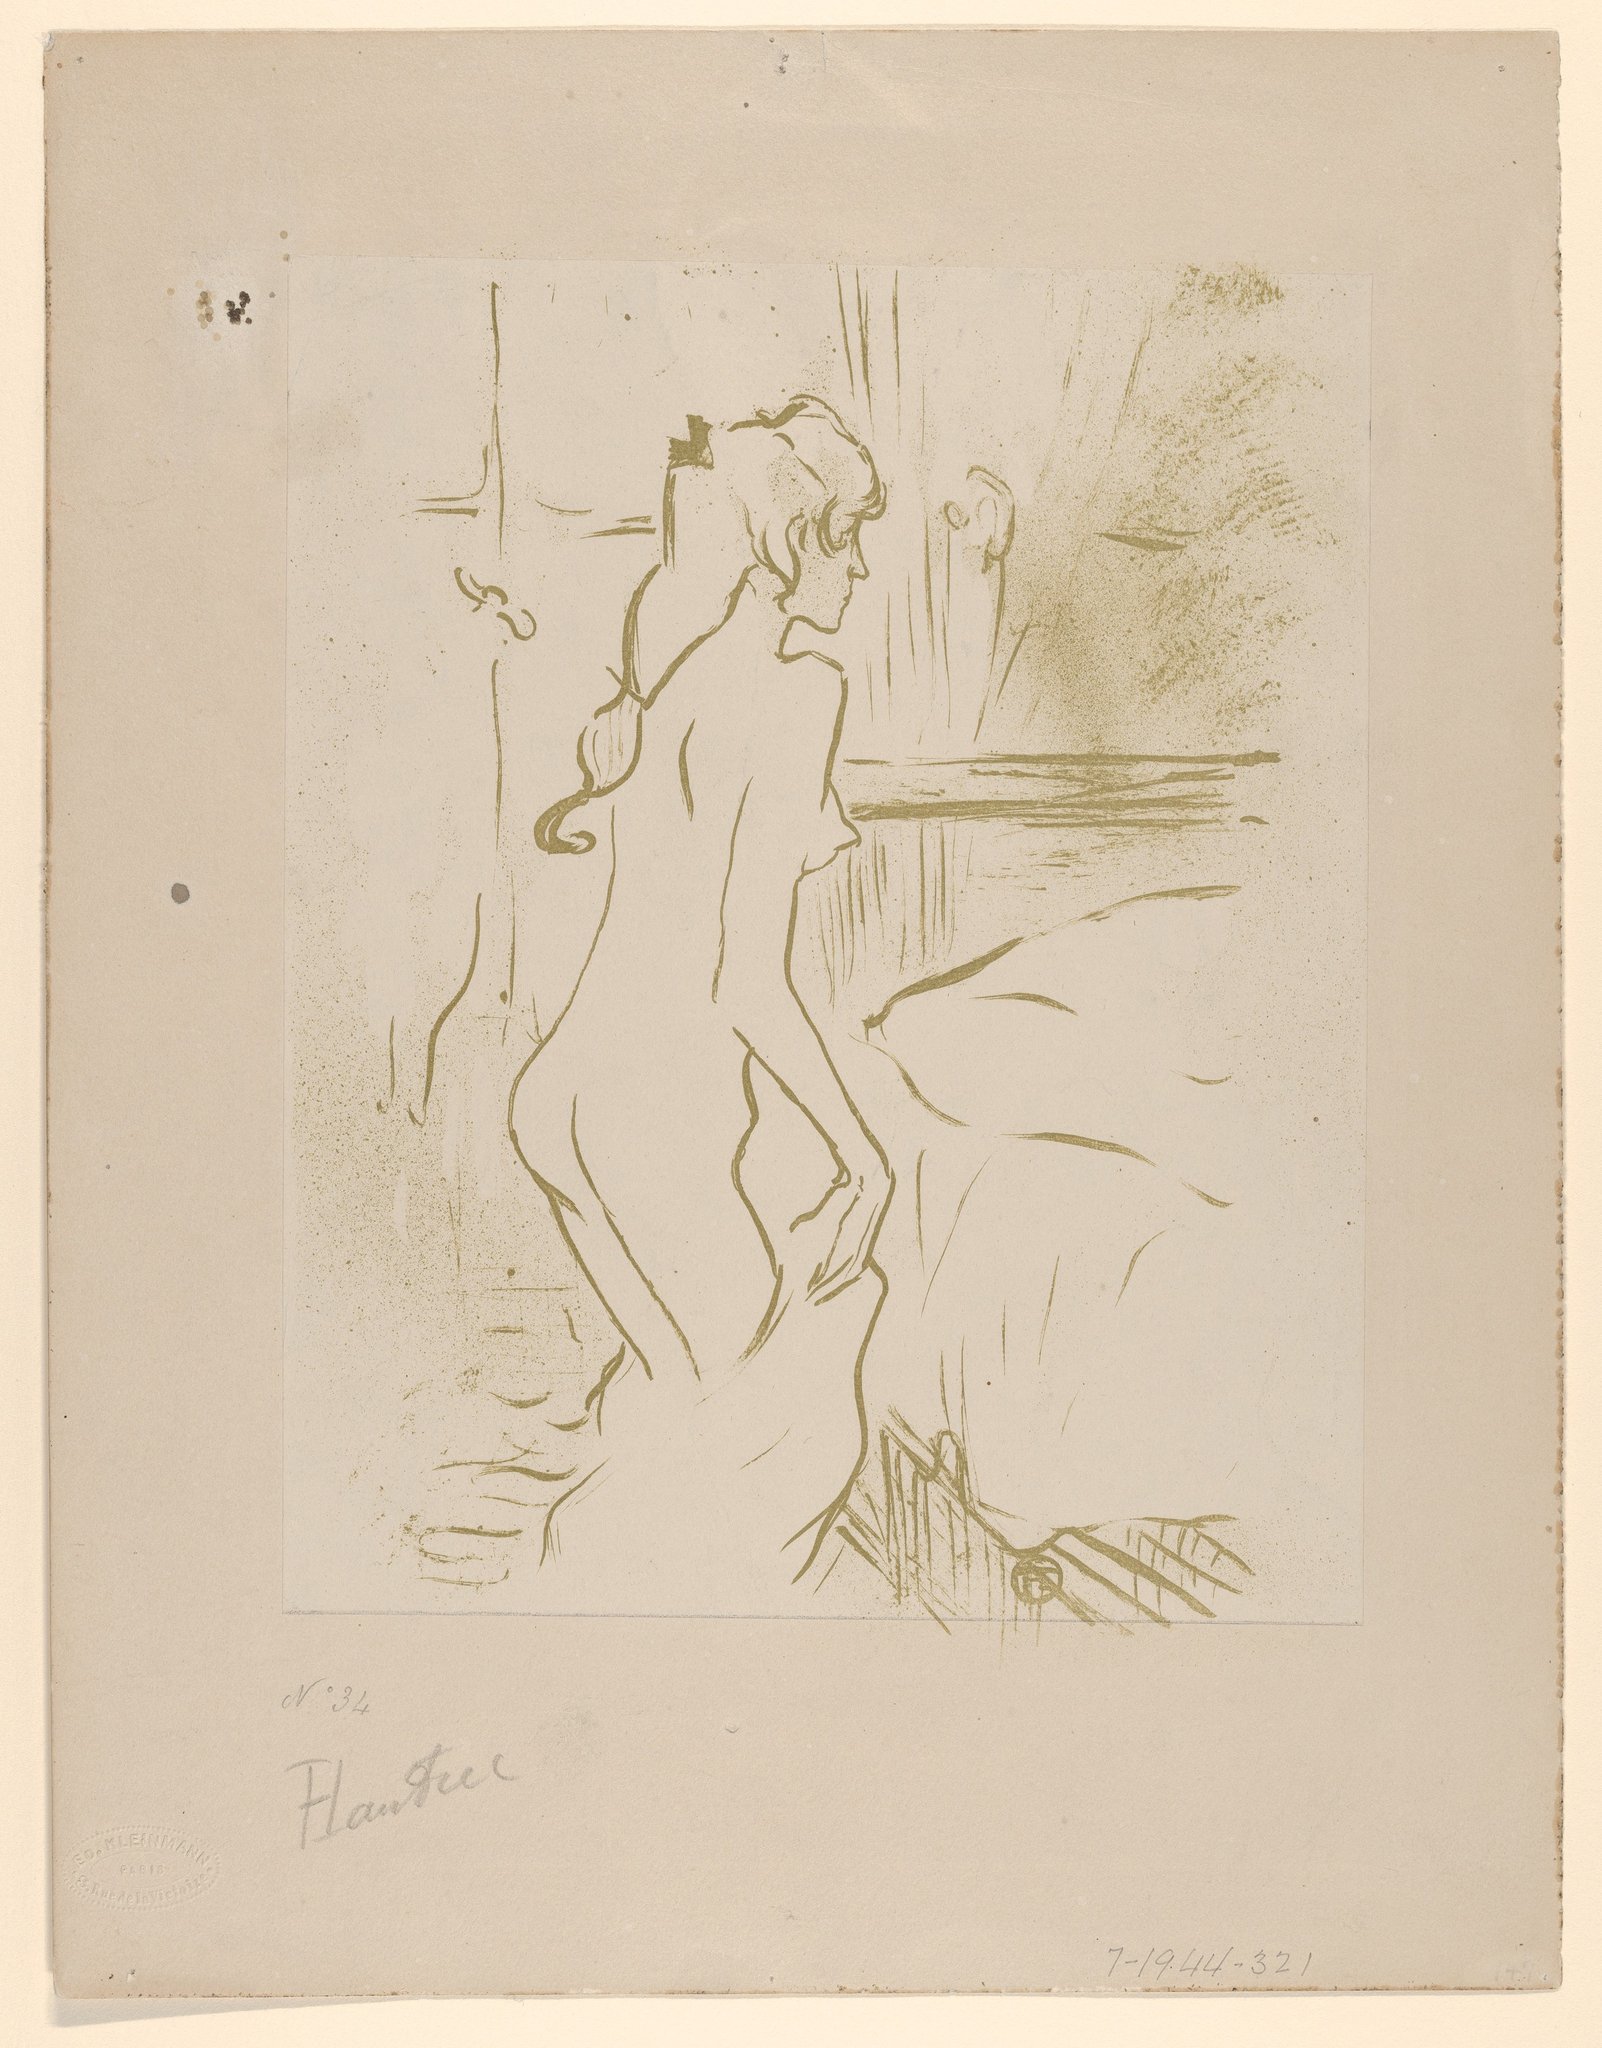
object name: print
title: Study of a Woman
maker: henri de toulouse-lautrec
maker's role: artist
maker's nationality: french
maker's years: 1864-1901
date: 1893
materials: paper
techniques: brush, lithograph, printing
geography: france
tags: female nudes